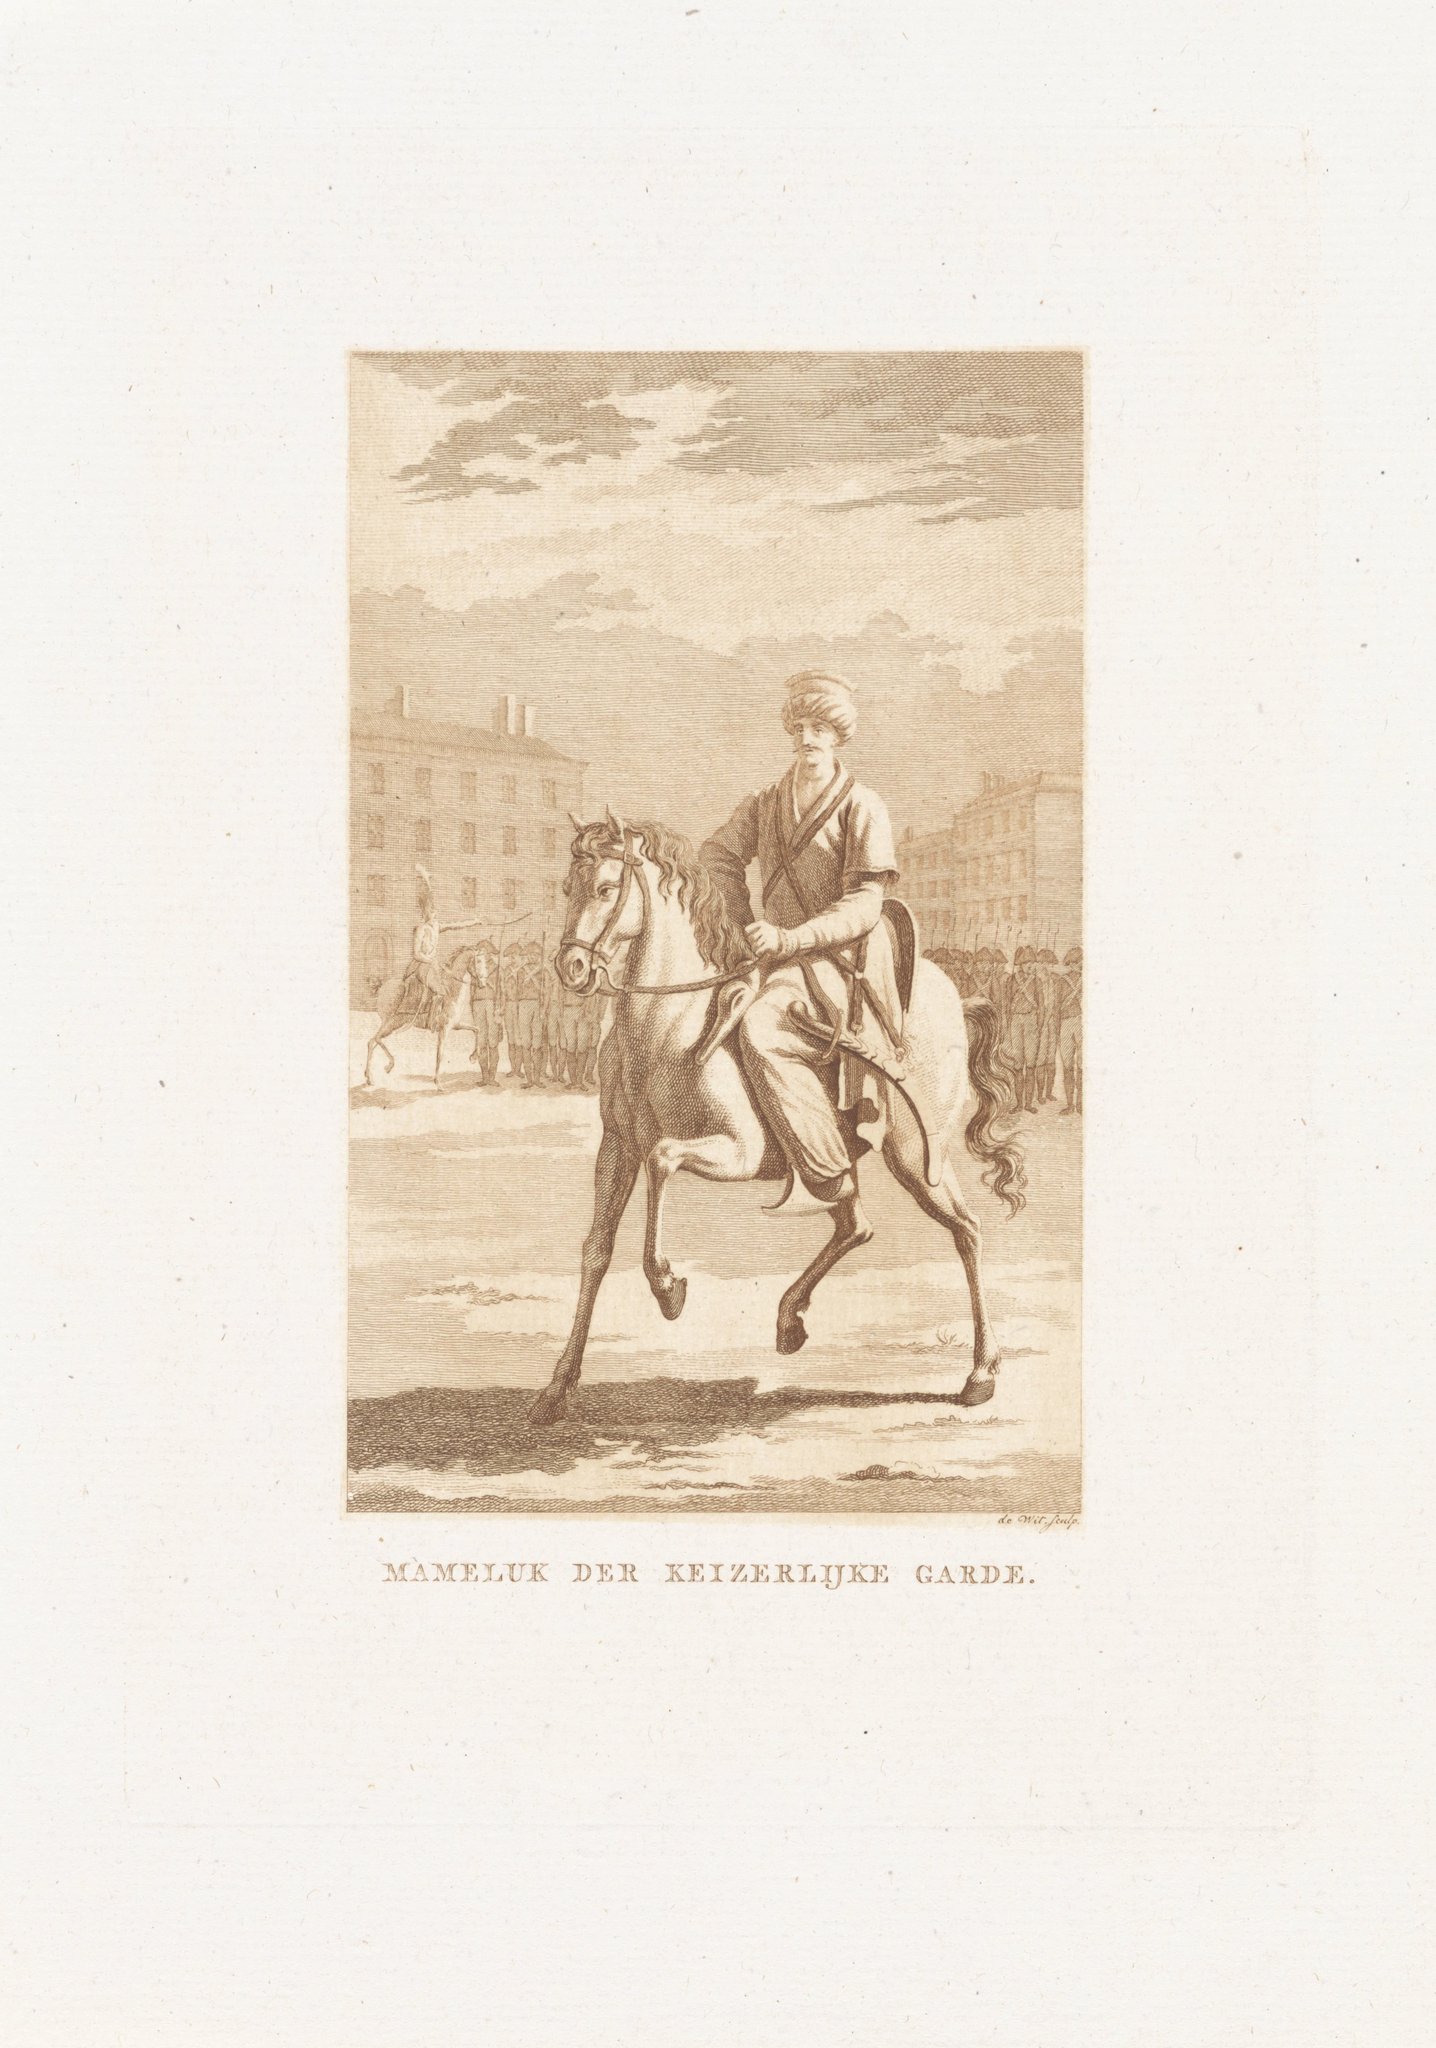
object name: print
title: Mameluk der keizerlijke garde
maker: izaak jansz. de wit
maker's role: draughtsman, print maker, publisher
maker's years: 1744-1809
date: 1798-1809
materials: paper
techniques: etching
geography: haarlem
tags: riding a horse, ass, or mule; rider, horseman, asiatic races and peoples: turks, head-gear: turban, slavery; serfs and enslaved persons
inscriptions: collector's mark: Lugt 2228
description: Turkse ruiter, achter hem soldaten. In 1798 viel Napoleon Egypte binnen en versloeg de Mammelukken. Napoleon was onder de indruk van de Mammelukse cavalerie en formeerde een eigen Mammelukken-korps voor het Franse keizerlijke leger.